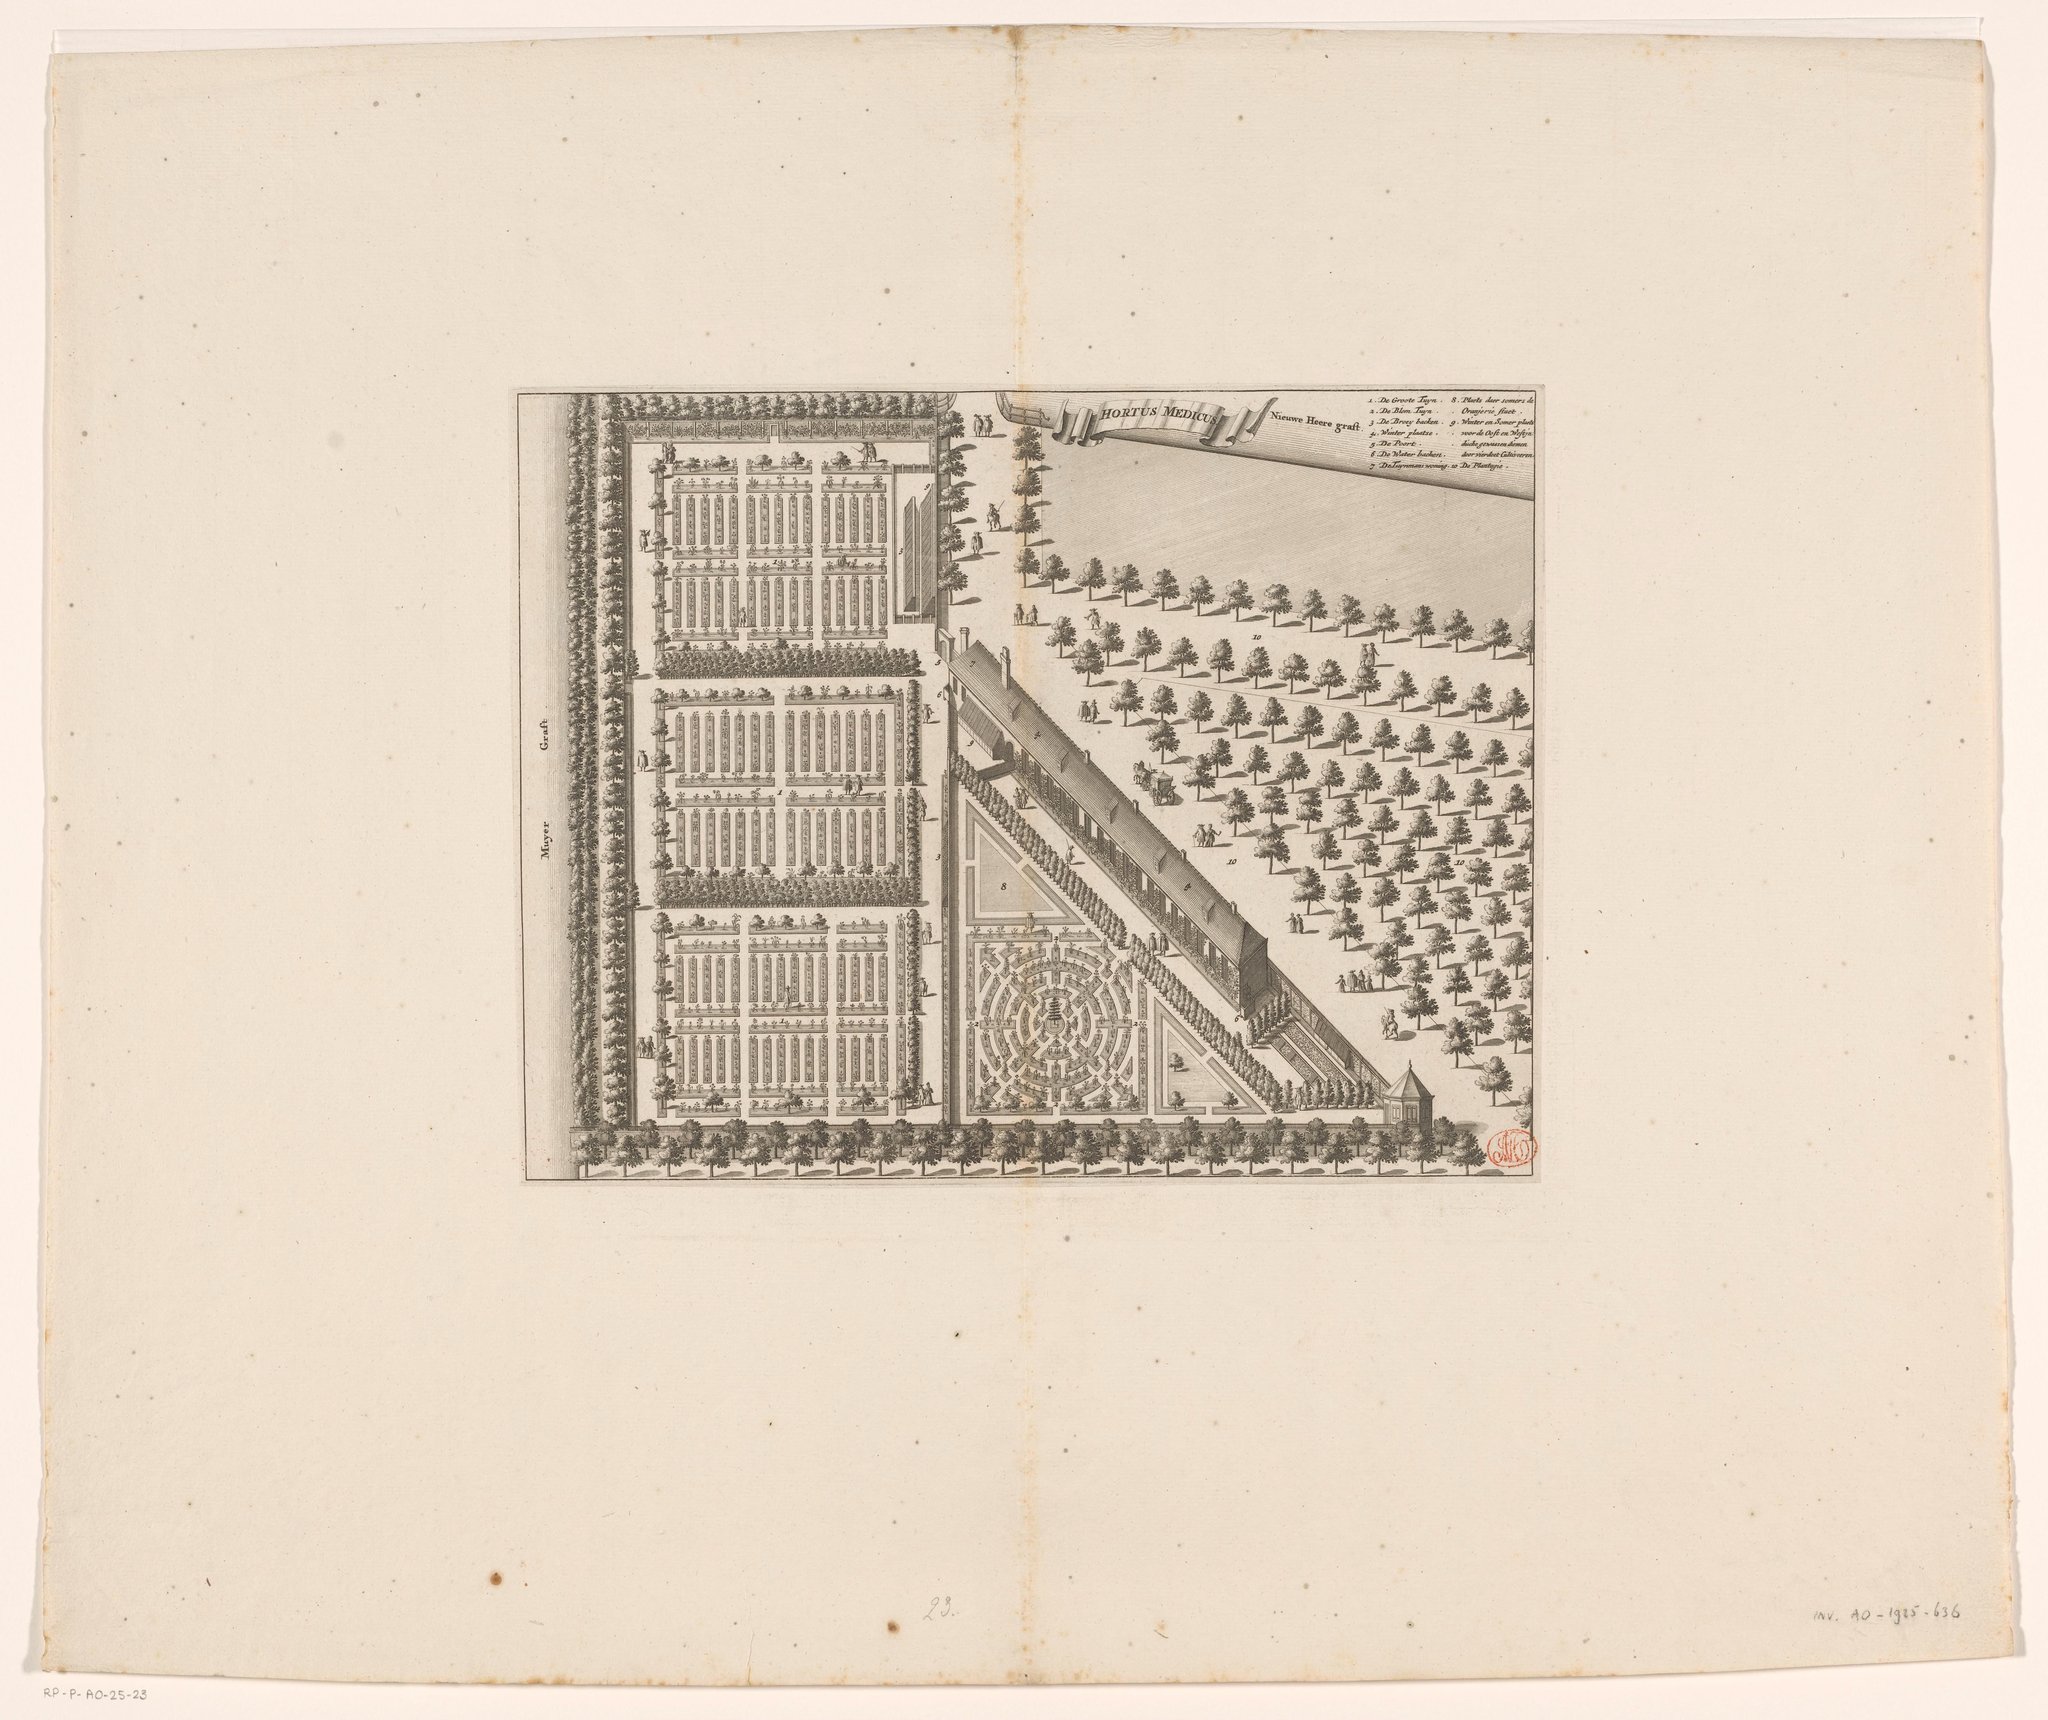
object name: print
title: Hortus Medicus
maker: Anonymous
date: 1693-1726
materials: paper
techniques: engraving, etching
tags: plan, map of garden, botanic garden, 'hortus botanicus'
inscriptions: collector's mark: Lugt 195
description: Prent ook gebruikt in: Commelin, Caspar. Beschryvinge van Amsterdam, desselfs eerste oorspronk uyt den Huyse (…). 2 delen. Amsterdam: Abraham Wolfgang, Gillis Janssonius van Waesberge, Johannes Janssonius van Waesberge II, weduwe Dirk Boom I, Hendrick Boom en Rembertus Goethals, 1693. En in: Commelin, Caspar. Beschryvinge van Amsterdam, zynde een naukeurige verhandelinge van desselfs eerste oorspronk uyt (…). 2 delen. Amsterdam: weduwe Aart Dircksz Oossaan, 1694. En in: Commelin, Caspar. Beschryvinge van Amsterdam, zynde een naukeurige verhandelinge van desselfs eerste oorspronk uyt (…). 2 delen. 2e druk. Amsterdam: Andries van Damme, Johannes Ratelband, weduwe A. van Aaltwyk en Hermanus Uytwerf, 1726.